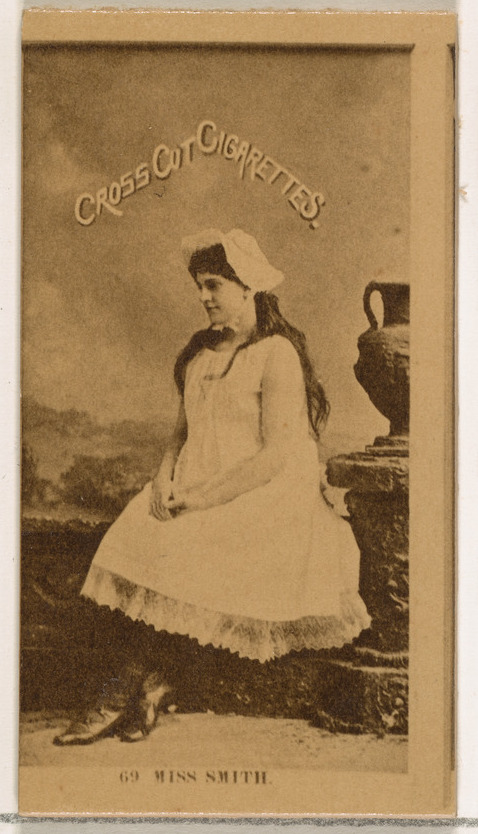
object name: print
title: Card Number 69, Miss Smith, from the Actors and Actresses series (N145-2) issued by Duke Sons & Co. to promote Cross Cut Cigarettes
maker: w. duke, sons & co.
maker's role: publisher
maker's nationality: american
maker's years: 1870-1920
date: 1880-1889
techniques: albumen silver print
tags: women,actresses